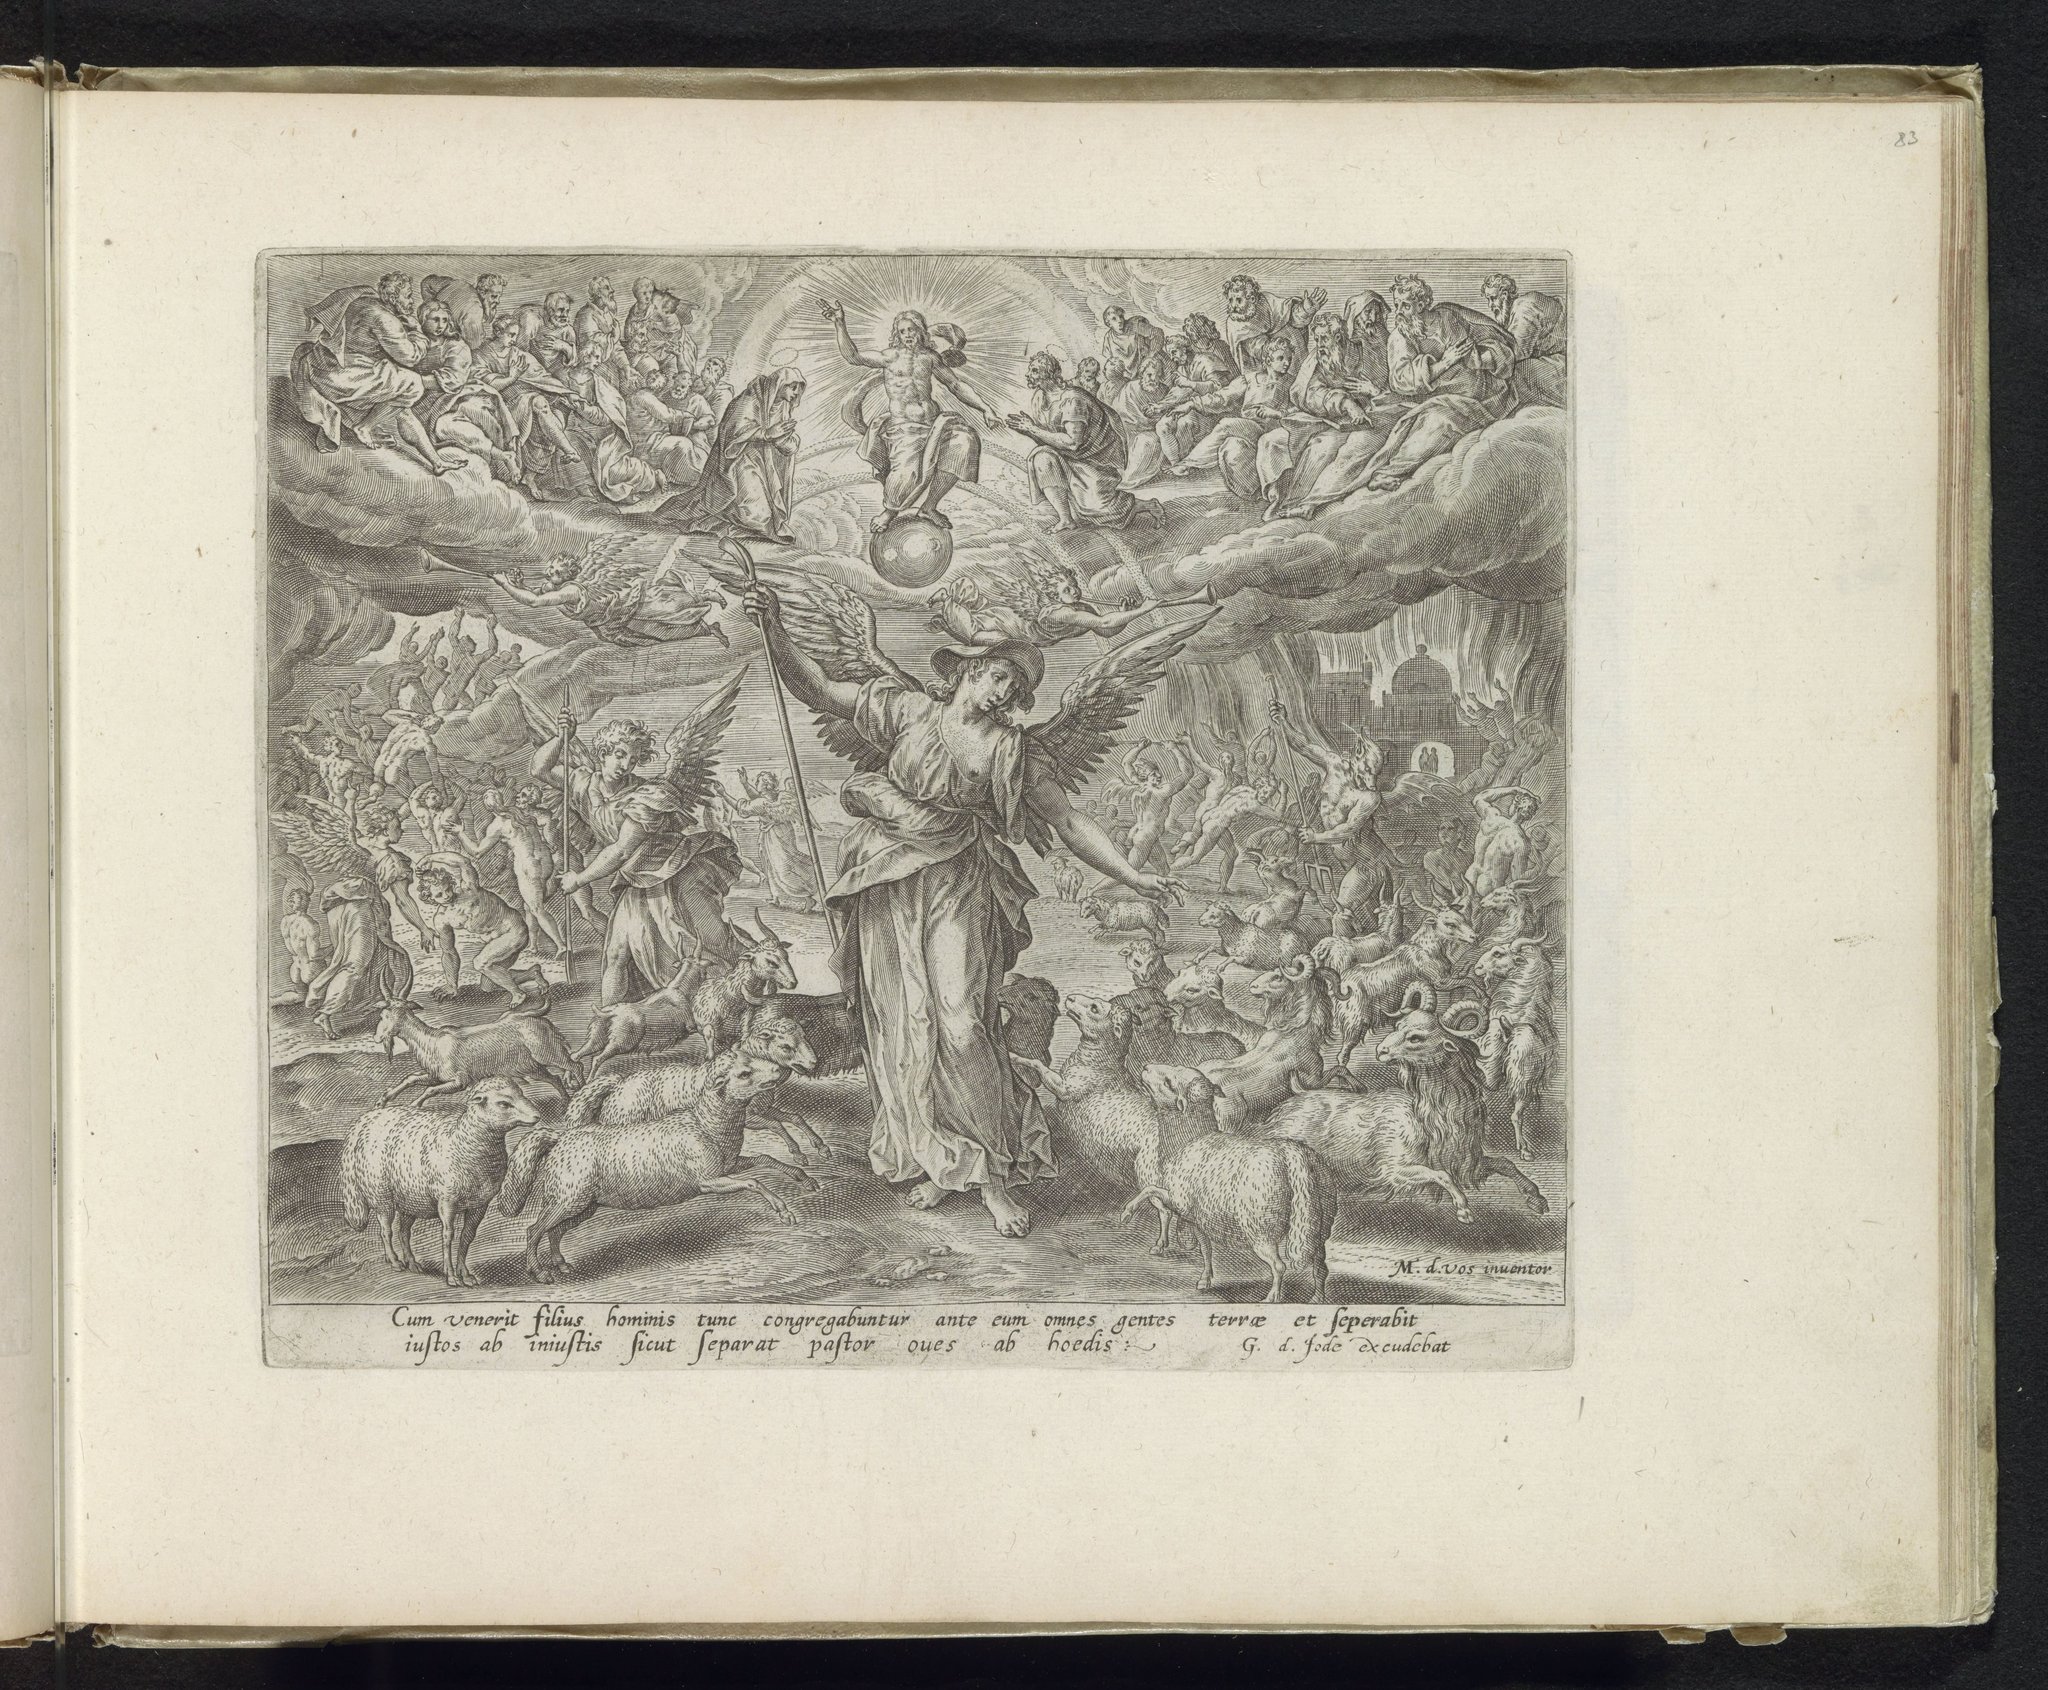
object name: print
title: Scheiden van de schapen en de bokken en het laatste oordeel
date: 1585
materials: paper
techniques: engraving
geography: antwerp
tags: 'as a shepherd (the son of man) separates the sheep from the goats' (matthew 25:32), representation of last judgement, with the archangel michael weighing the souls (or dividing the blessed and the damned)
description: De aartsengel Michael scheidt de schapen van de bokken. Christus troont op de wolken, geflankeerd door Maria en Johannes. De doden worden door engelen naar de hemel geleid (links) of naar de hel gevoerd (rechts). Onder de voorstelling een verwijzing in het Latijn naar de Bijbeltekst. Deze prent maakt deel uit van een album.